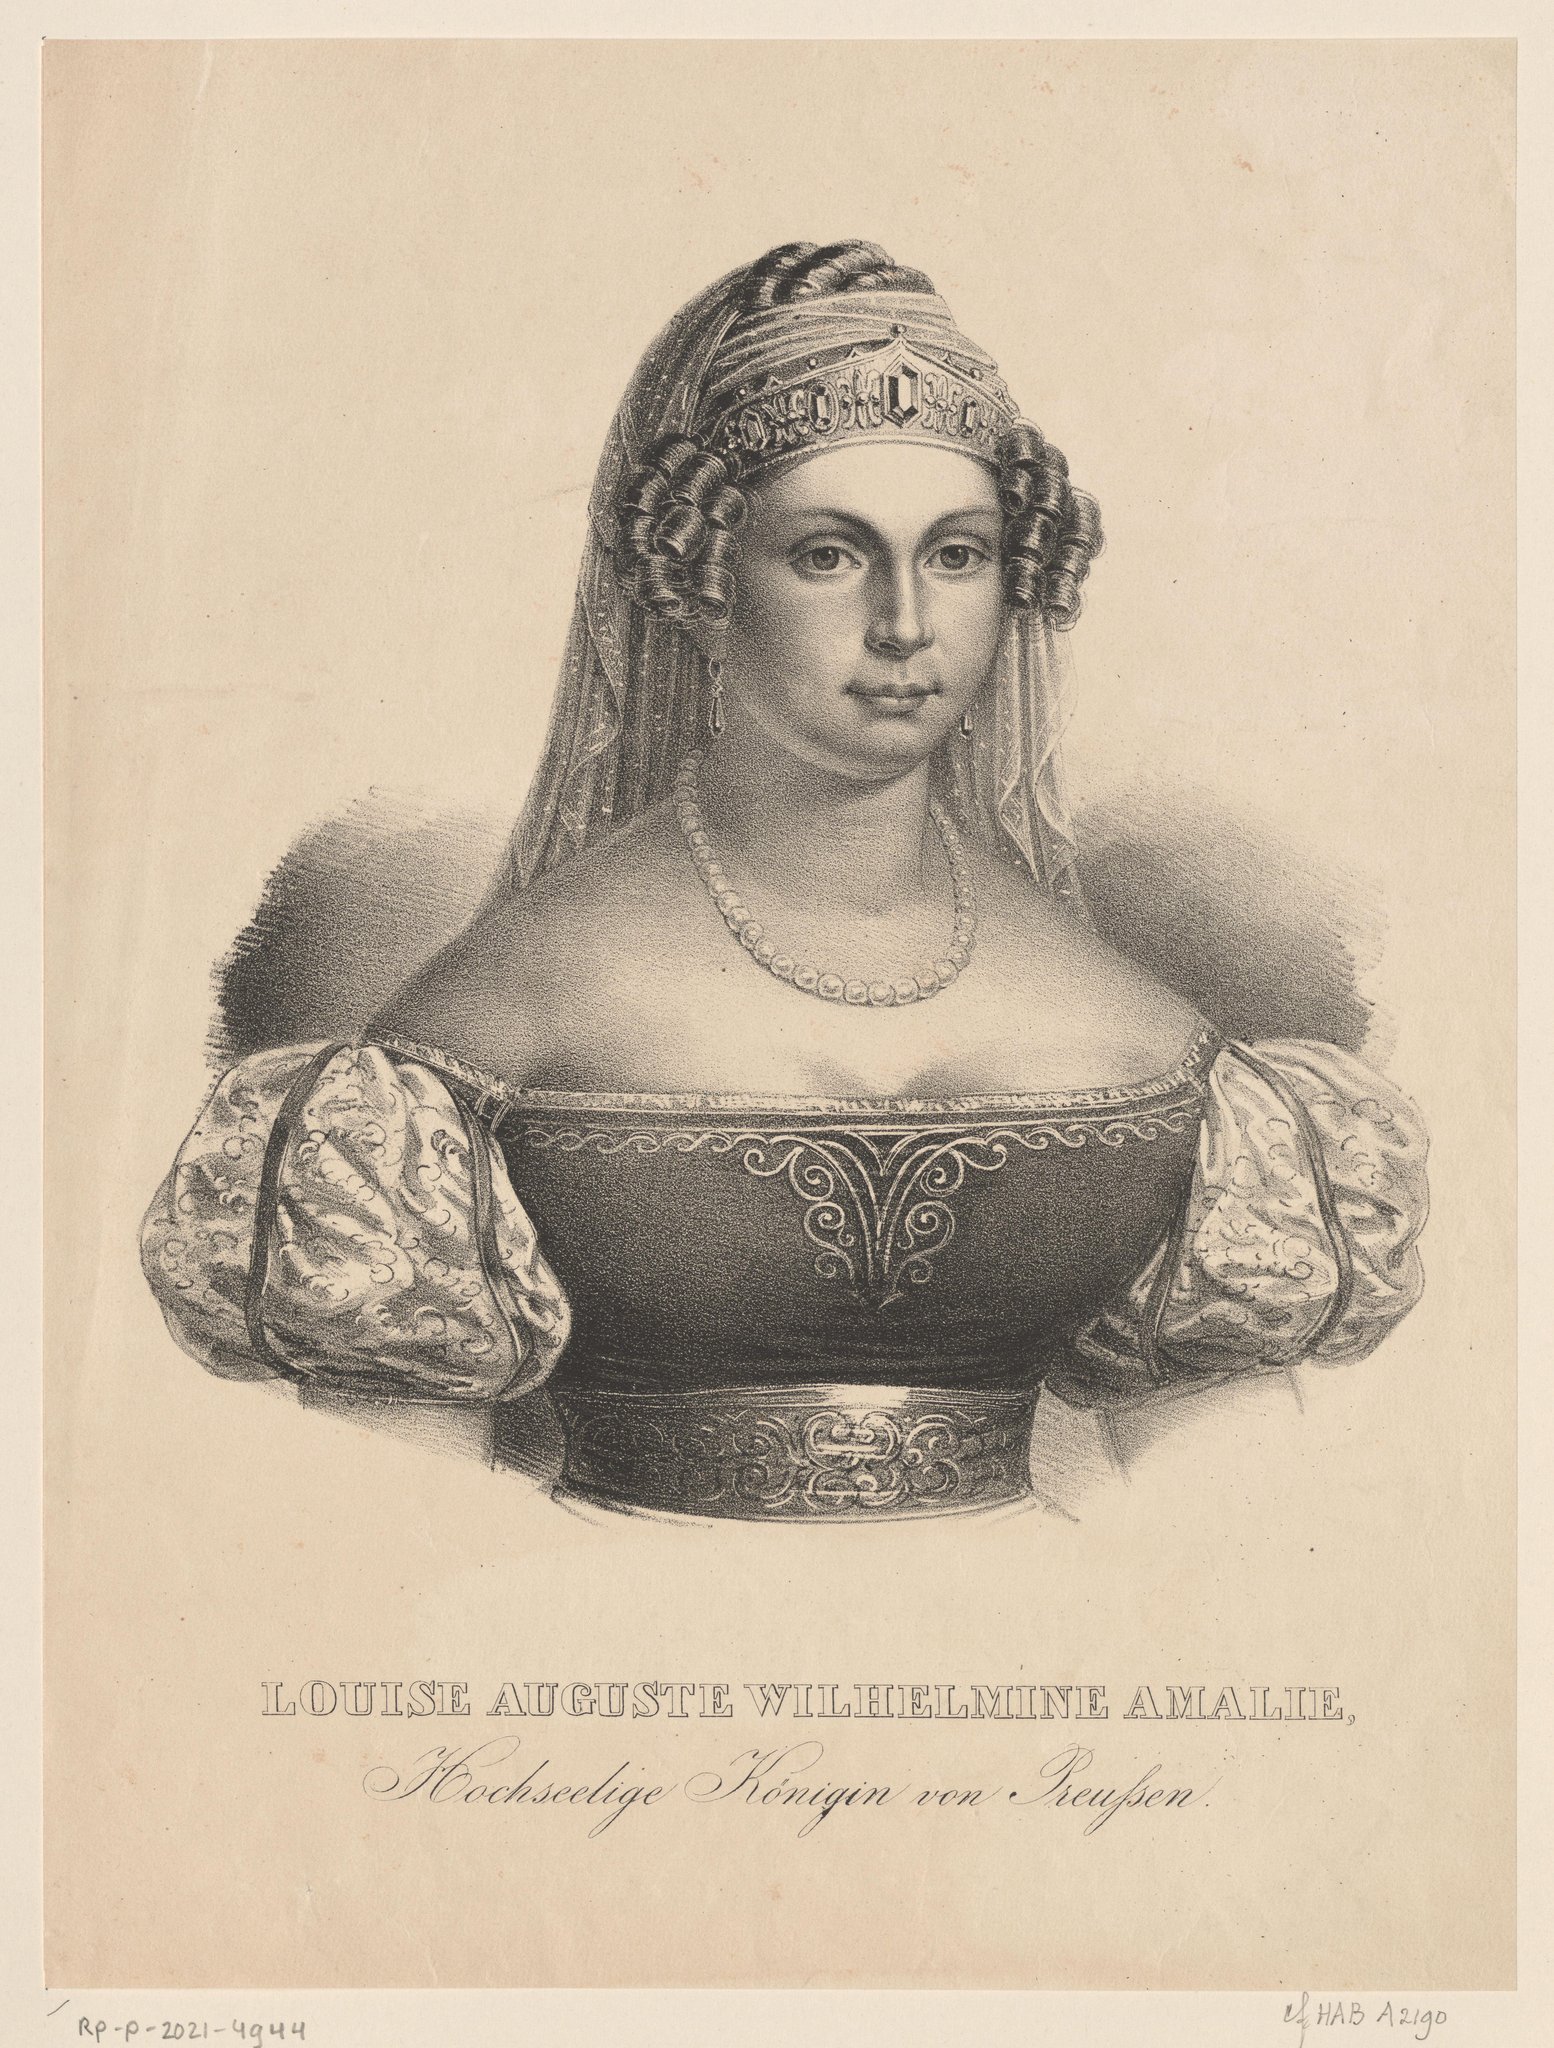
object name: print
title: Portret van Louise van Mecklenburg-Strelitz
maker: Anonymous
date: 1800-1899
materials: paper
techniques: lithograph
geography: germany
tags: crown (symbol of sovereignty), historical persons - bb - woman, queen, pearl; pearl necklace